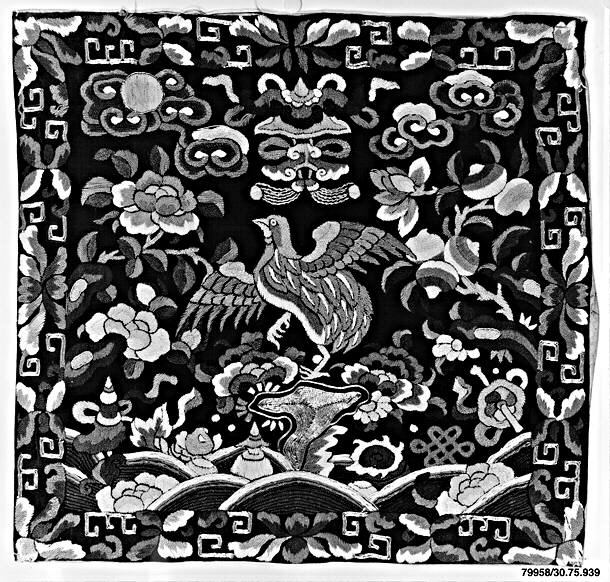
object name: rank badge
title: Rank Badge with Quail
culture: chinese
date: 1801-1900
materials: metal thread, silk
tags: birds